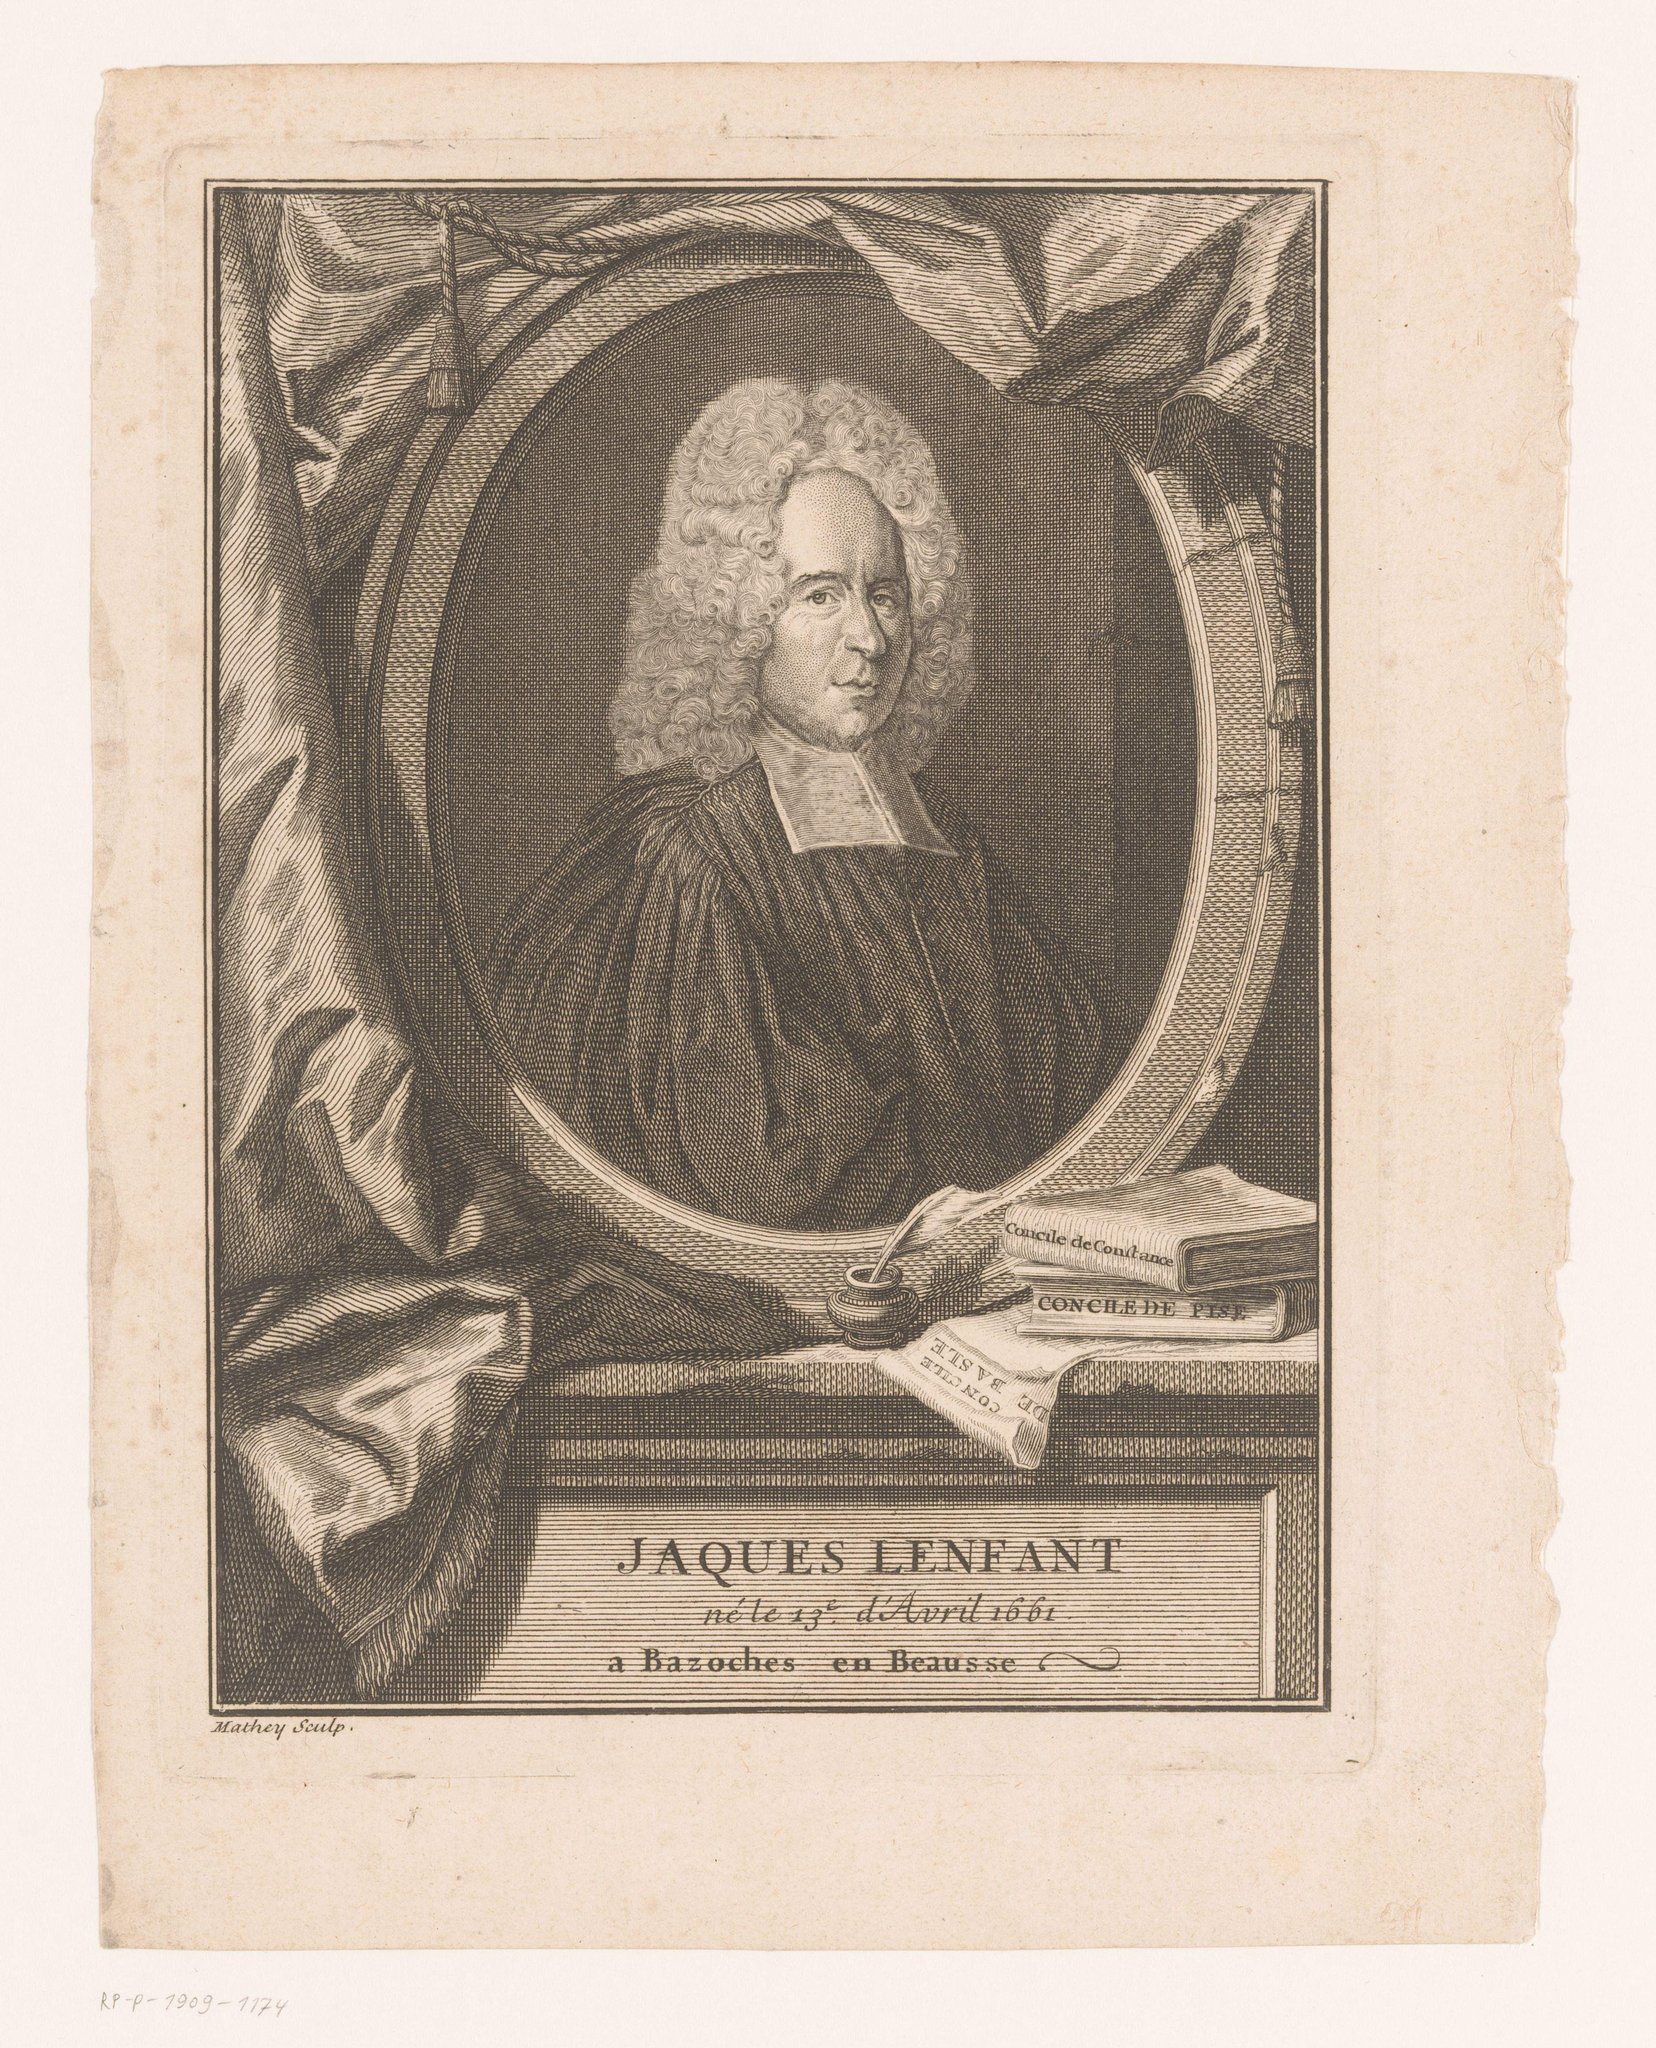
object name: print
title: Portret van Jacques Lenfant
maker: c. mathey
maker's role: print maker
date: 1700-1755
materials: paper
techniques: engraving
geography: france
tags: berlin, historical persons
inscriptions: collector's mark: Lugt 2228